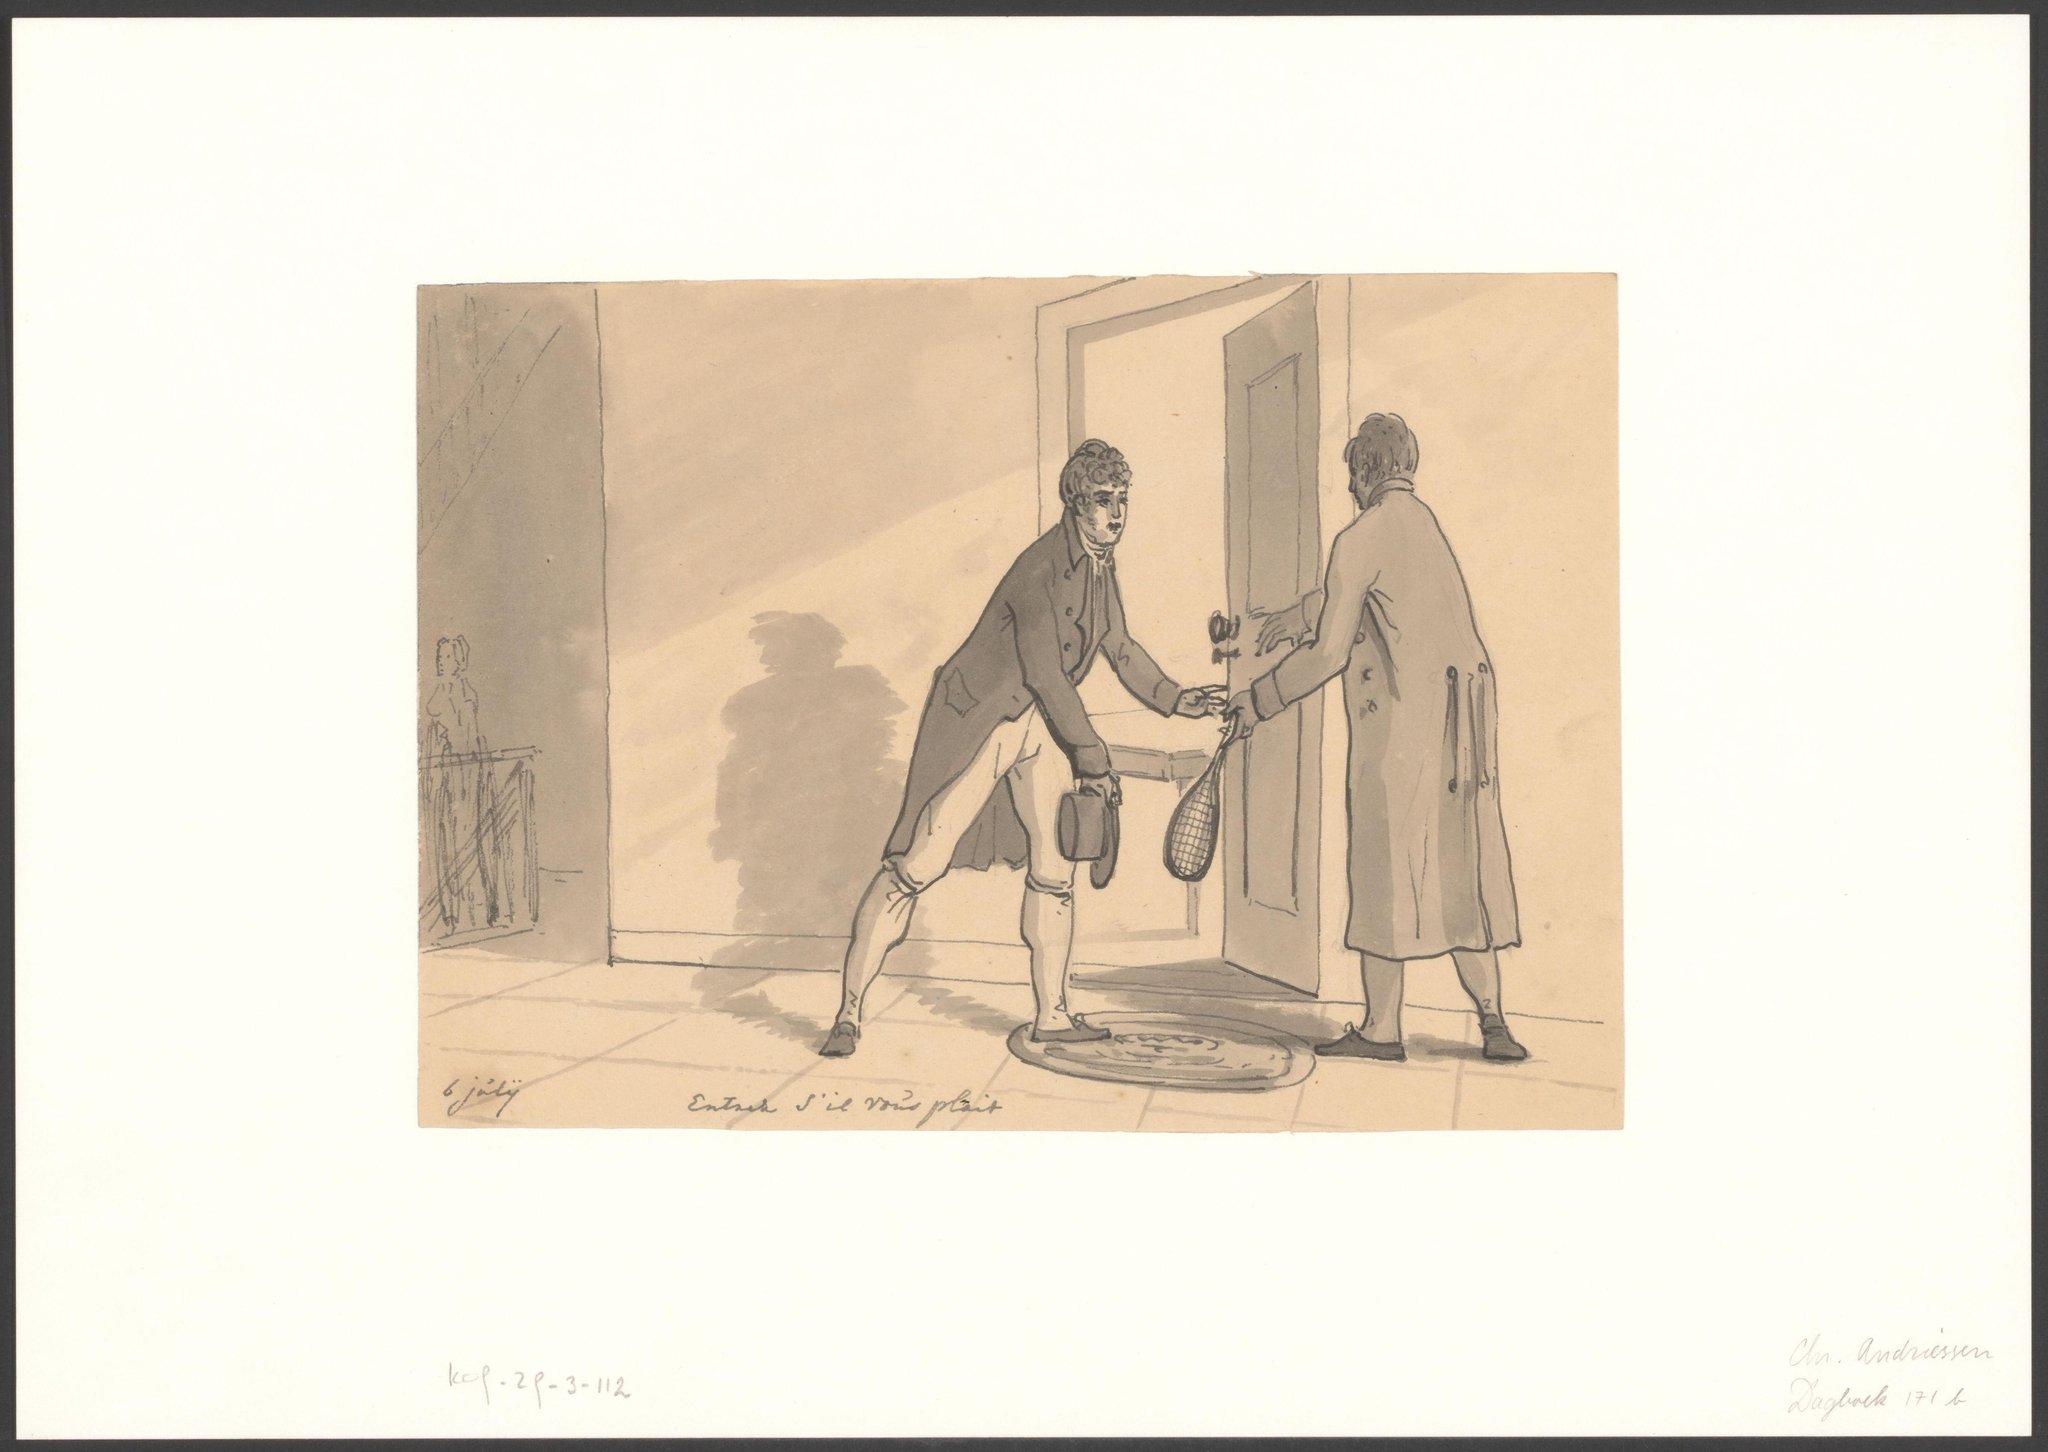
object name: drawing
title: Christiaan Andriessen laat een man met raket binnen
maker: christiaan andriessen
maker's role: draughtsman, print maker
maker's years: 1775-1846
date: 1805-1808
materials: ink, paper, pencil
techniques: brush, pen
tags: amsterdam, print maker, draughtsman, christiaan andriessen, opening the door, ball games in which ball is hit with racket (or hand)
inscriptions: inscription: ‘6 julij Entrez s'il vous plait’, signature: ‘J Andriessen’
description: Dagboekblad uit het getekende dagboek dat Christiaan Andriessen bijhield van 1805 tot en met 1808.